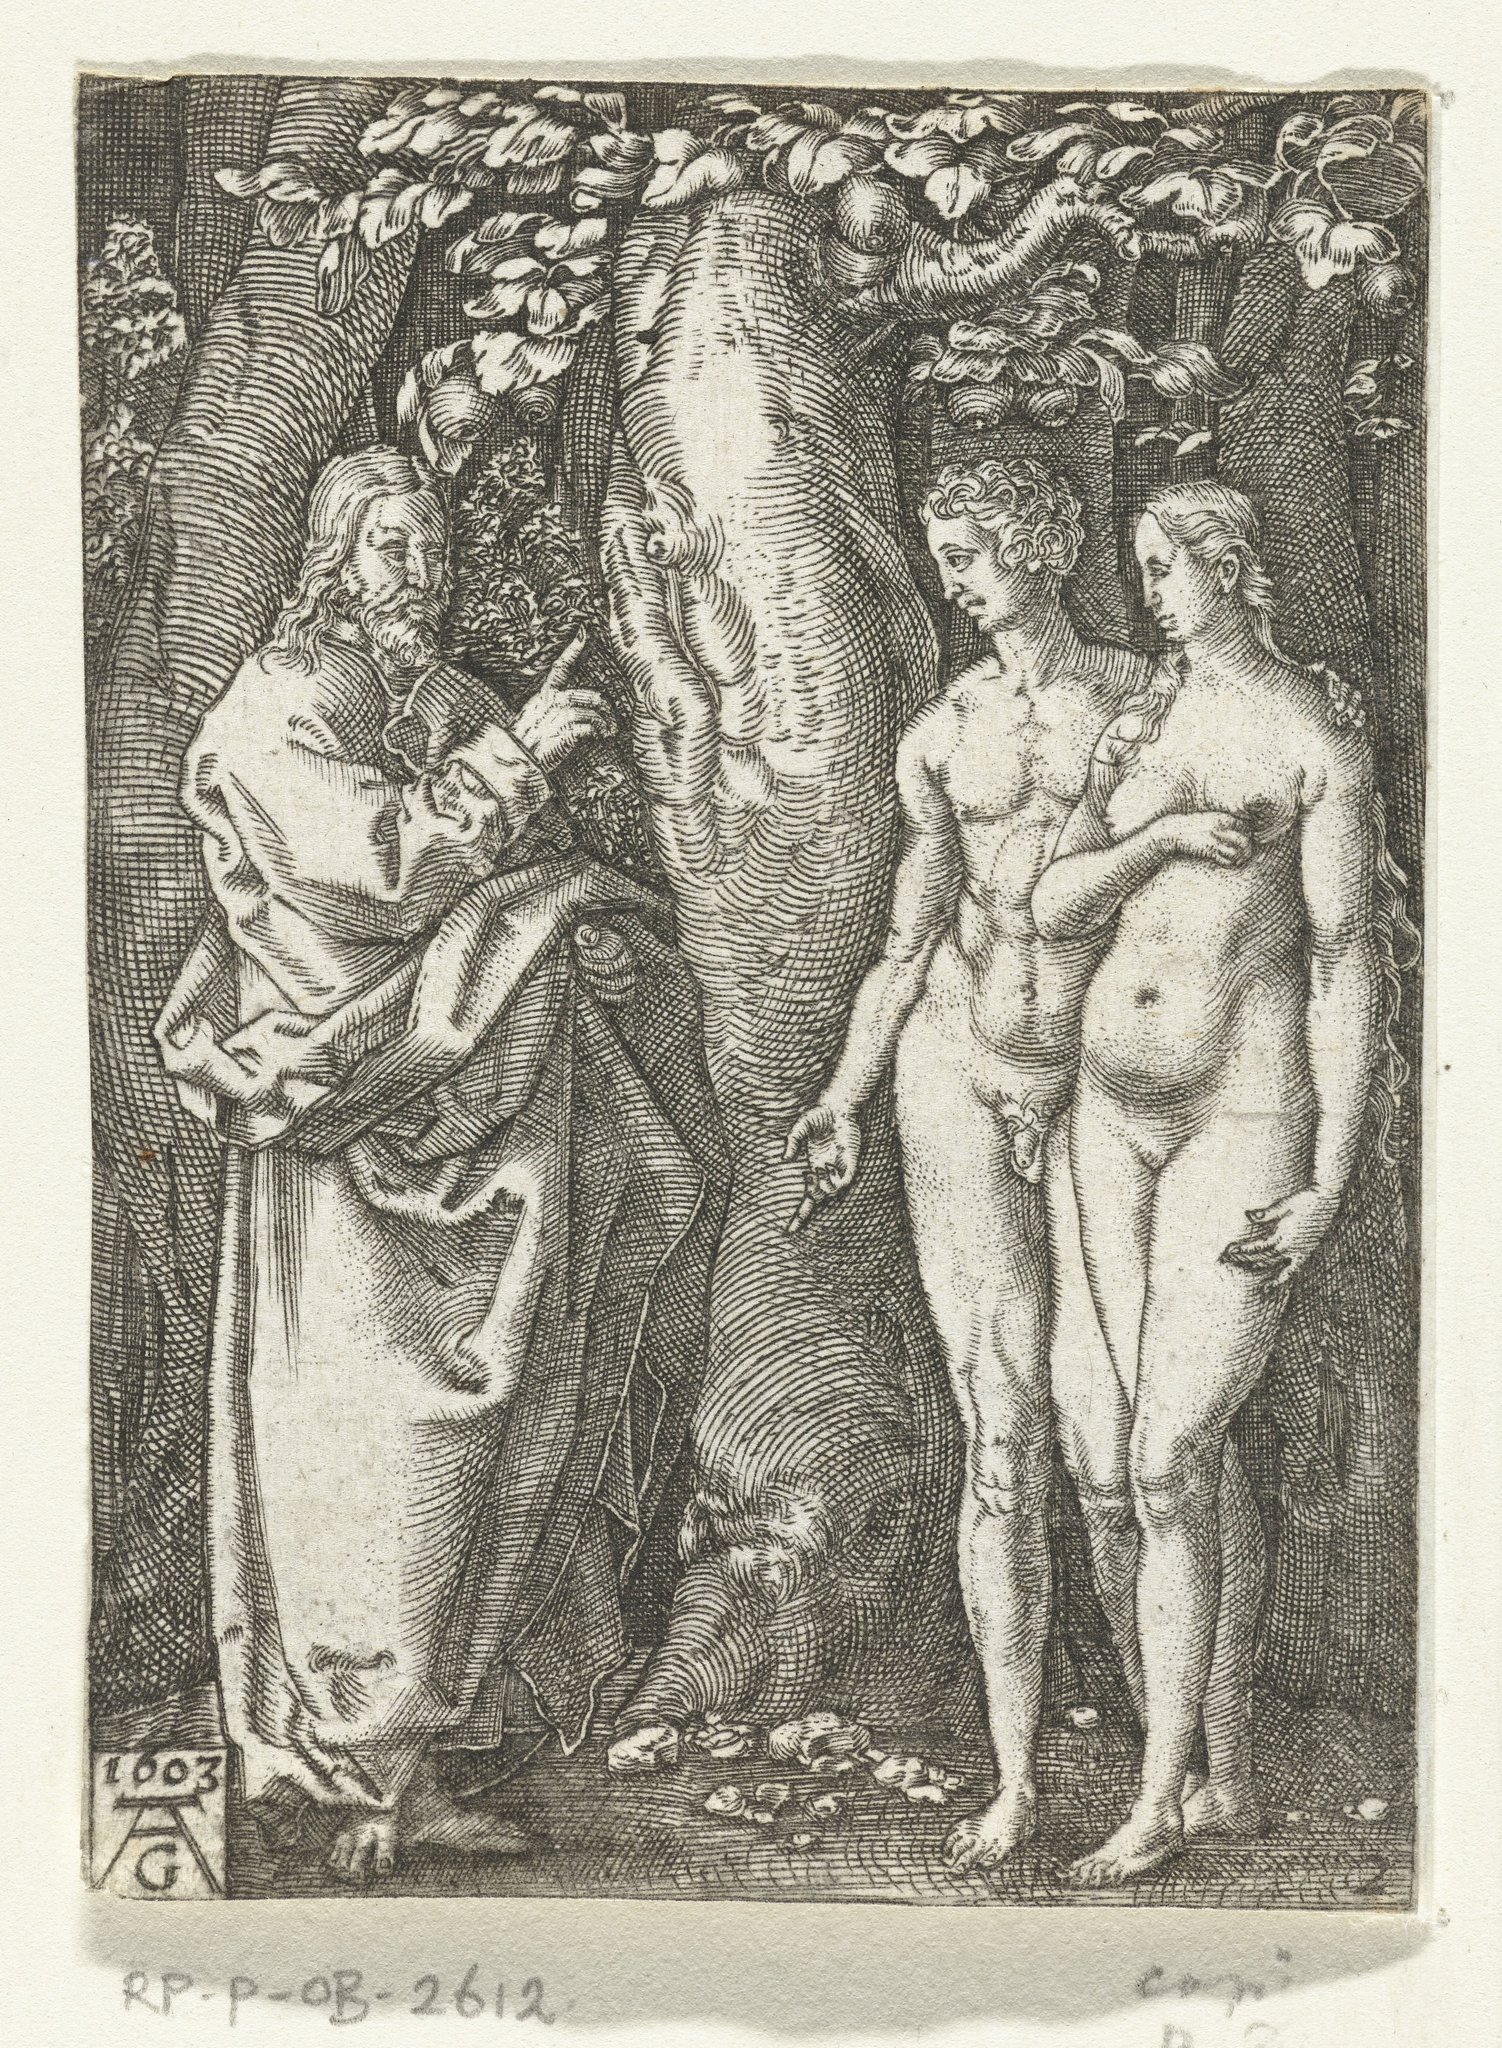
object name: print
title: Geschiedenis van Adam en Eva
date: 1603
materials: paper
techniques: engraving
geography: germany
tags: the giving of the test commandment: god warns adam and eve not to eat from the tree of knowledge of good and evil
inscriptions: date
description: God en de naakte Adam en Eva staan aan weerszijden van een vruchtboom, de boom van Goed en Kwaad. God, met de linker wijsvinger omhoog, waarschuwt hen hier niet van te eten.